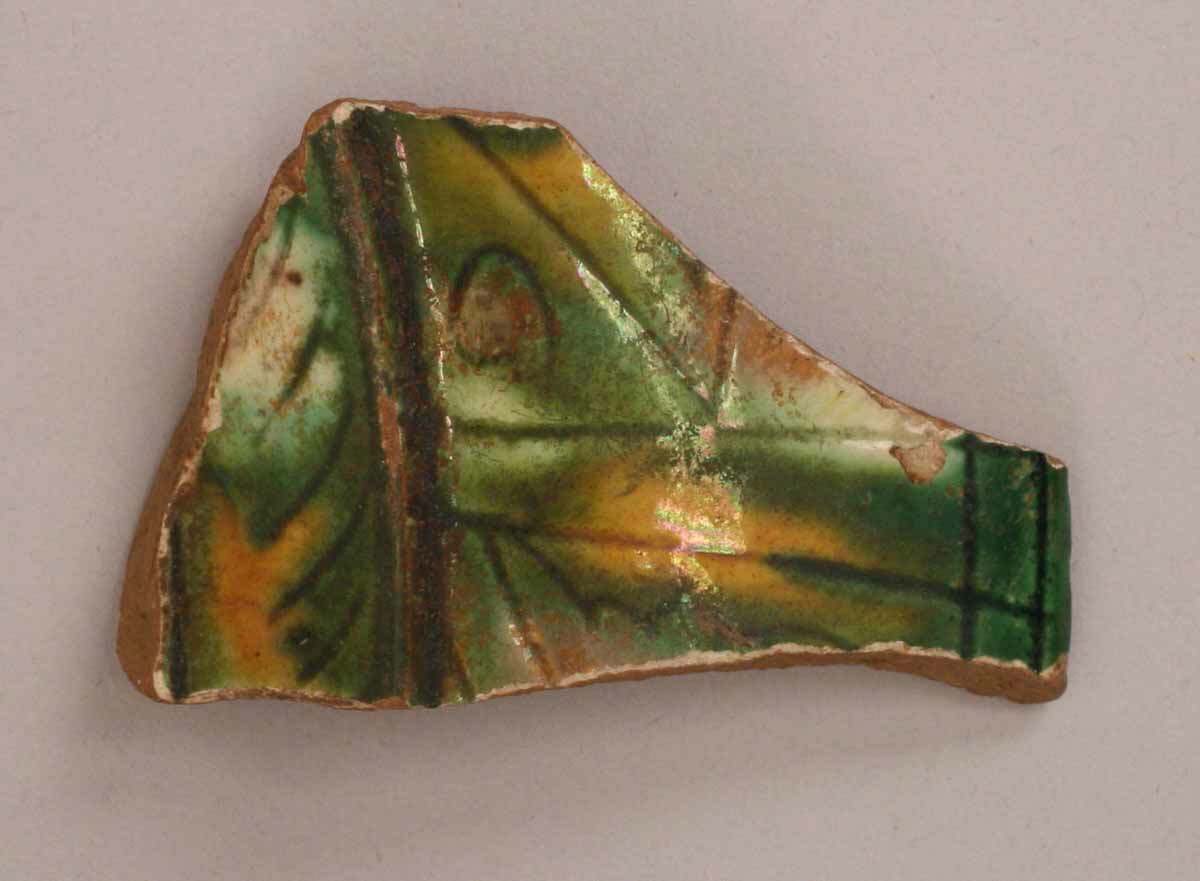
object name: fragment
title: Ceramic Fragment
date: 701-900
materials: earthenware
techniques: glazing, incising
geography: iraq